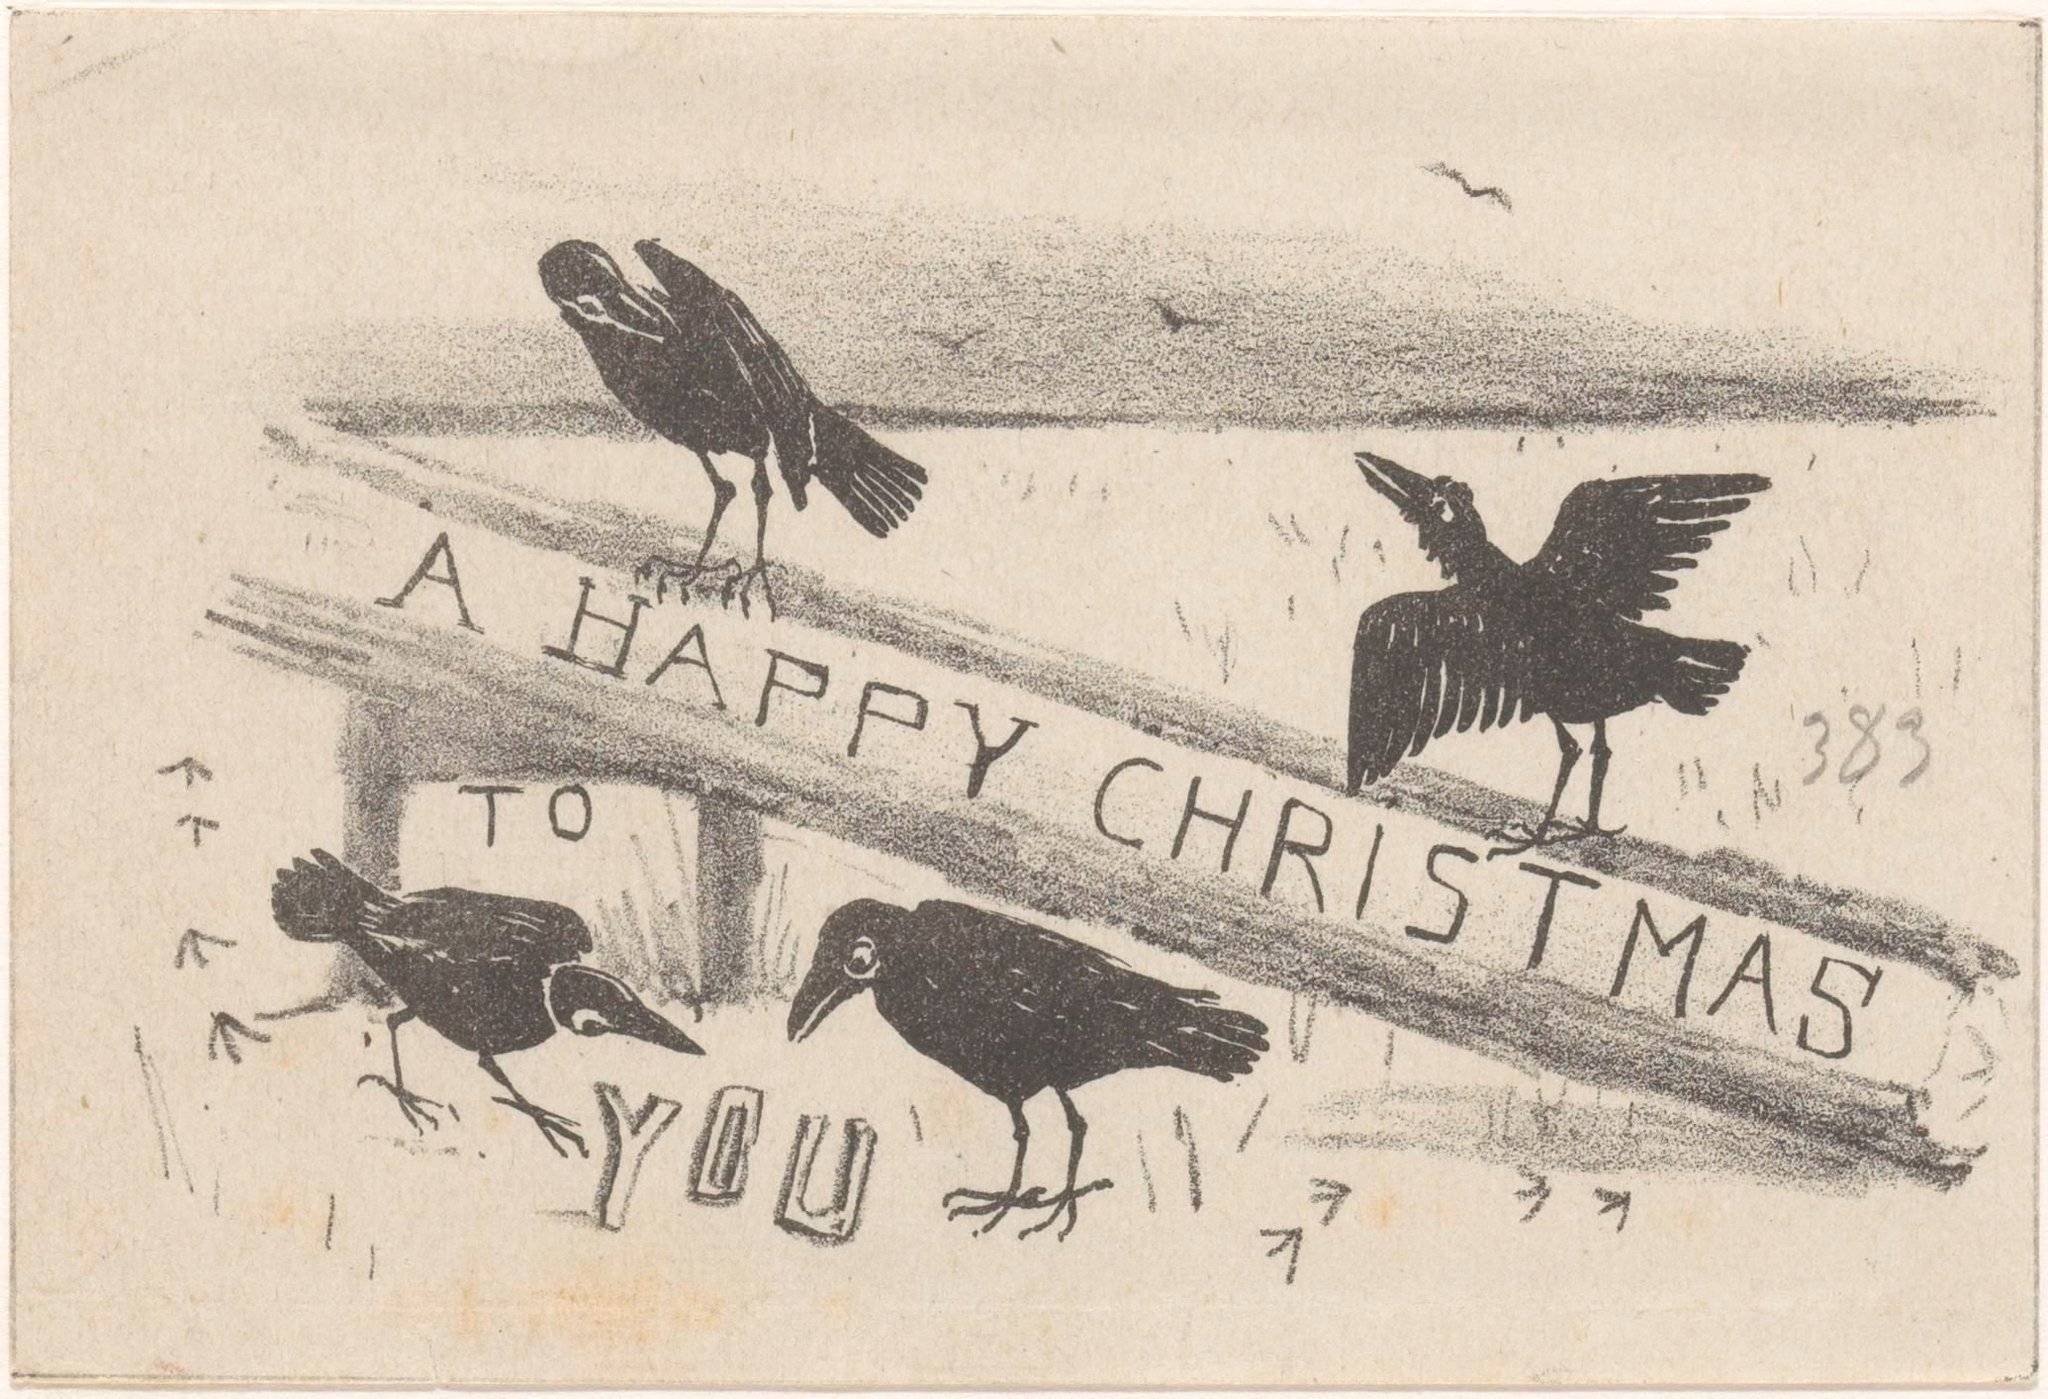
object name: print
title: Kerstkaart met vier kraaien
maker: theo van hoytema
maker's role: draughtsman, painter, print maker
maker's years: 1863-1917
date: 1878-1917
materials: paper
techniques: lithograph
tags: song-birds: crow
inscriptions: number: ‘383’, collector's mark: Lugt 2228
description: Vier kraaien bij een hek met de tekst 'A happy Christmas to you'.